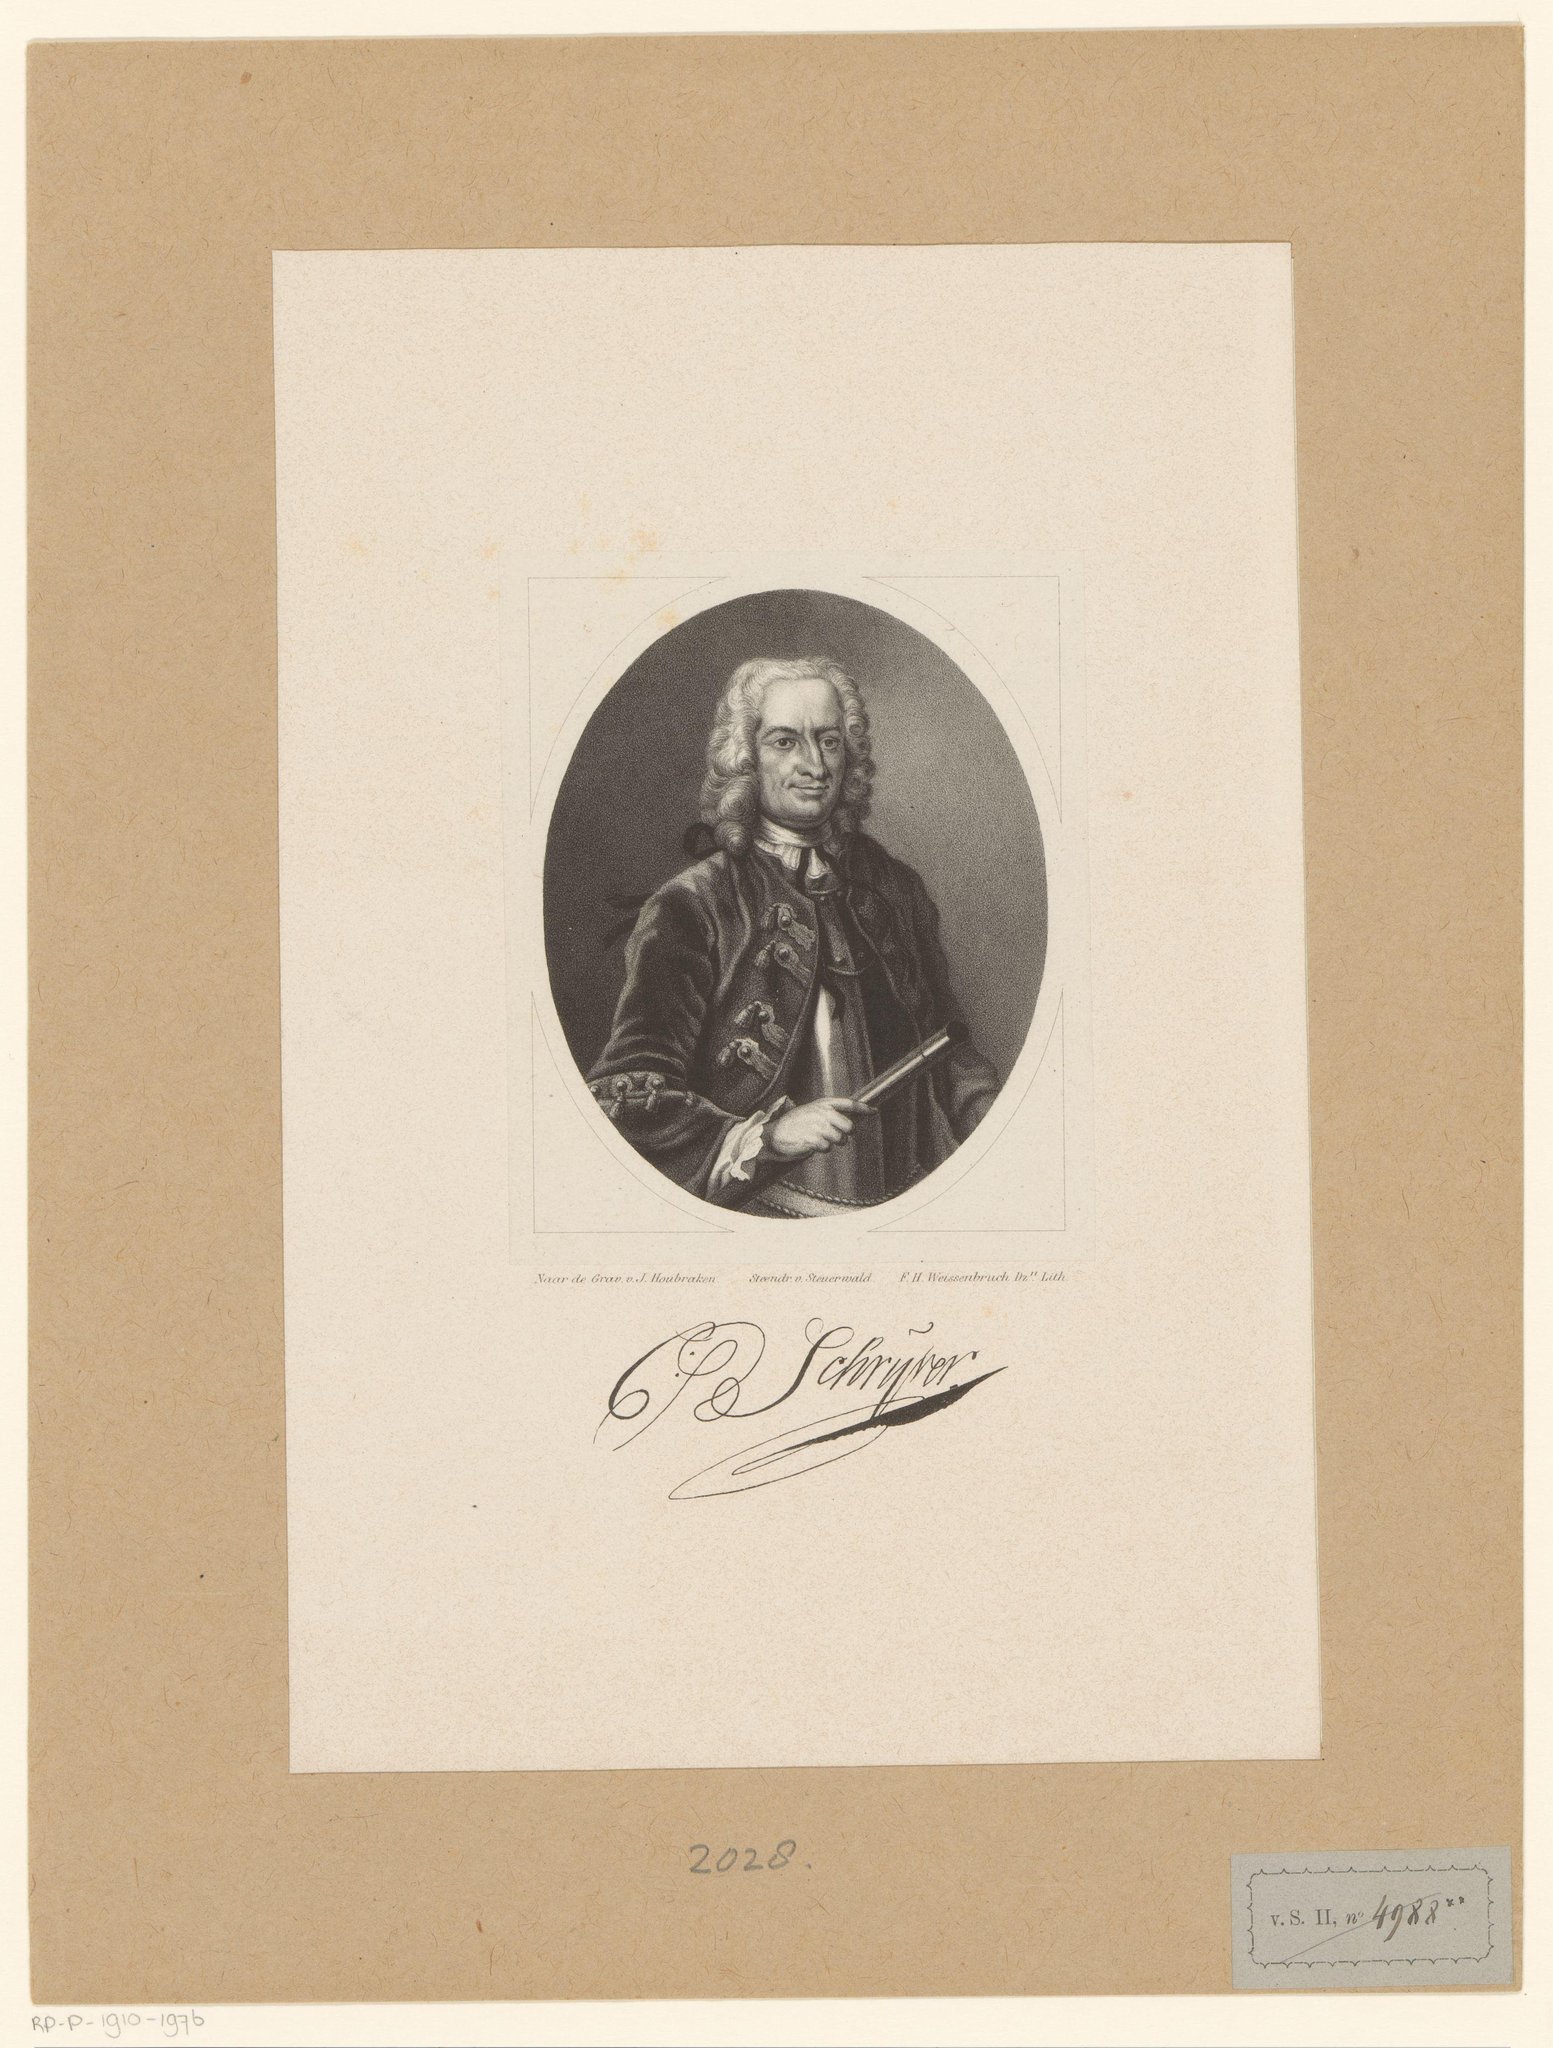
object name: book illustration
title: Portret van Cornelis Schrijver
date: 1858-1862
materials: paper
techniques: lithograph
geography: the hague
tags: amsterdam, historical persons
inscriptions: collector's mark: Lugt 2228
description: Prent uit: Jonge, J.C. de. Geschiedenis van het Nederlandsche zeewezen. Haarlem: Jonge, J.K.J. de, 1858-62.